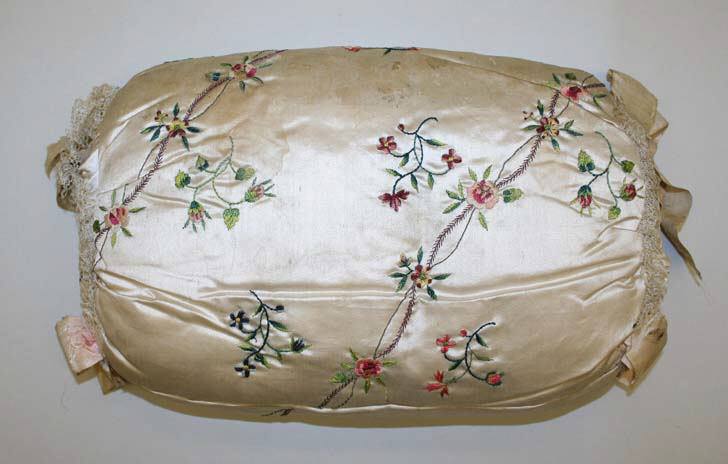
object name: muff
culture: british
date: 1780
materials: metal thread, silk